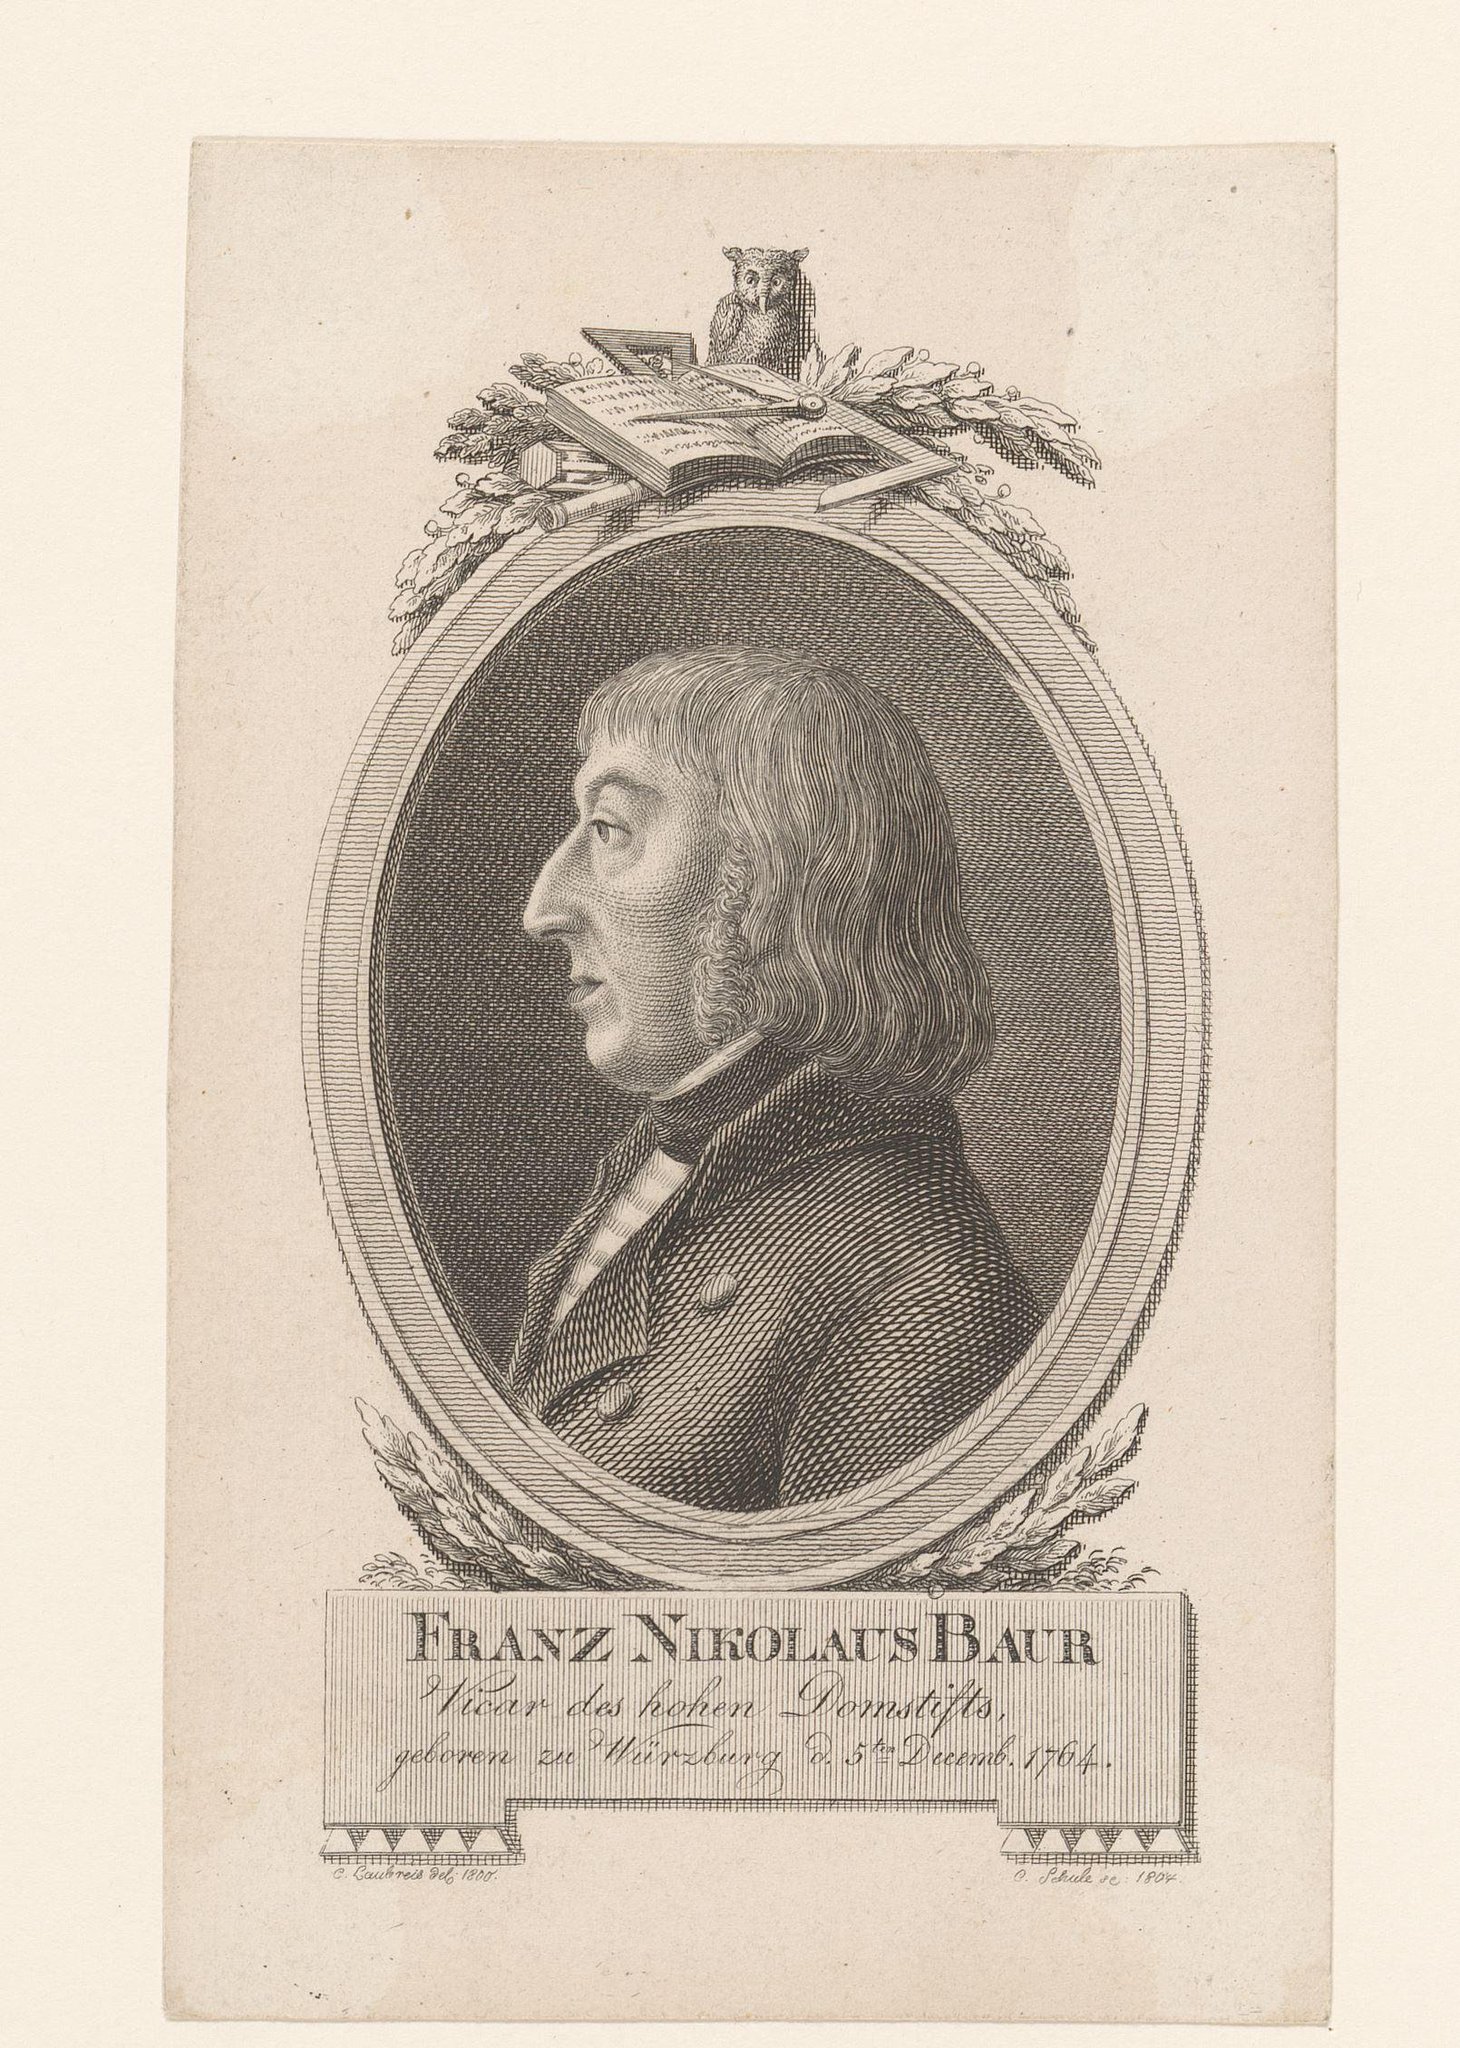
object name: print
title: Franz Nikolaus Baur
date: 1804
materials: paper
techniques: engraving, etching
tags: theologian, historical persons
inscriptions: collector's mark: Lugt 2228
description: Portret van Franz Nikolaus Baur, Duits vicaris en theoloog.